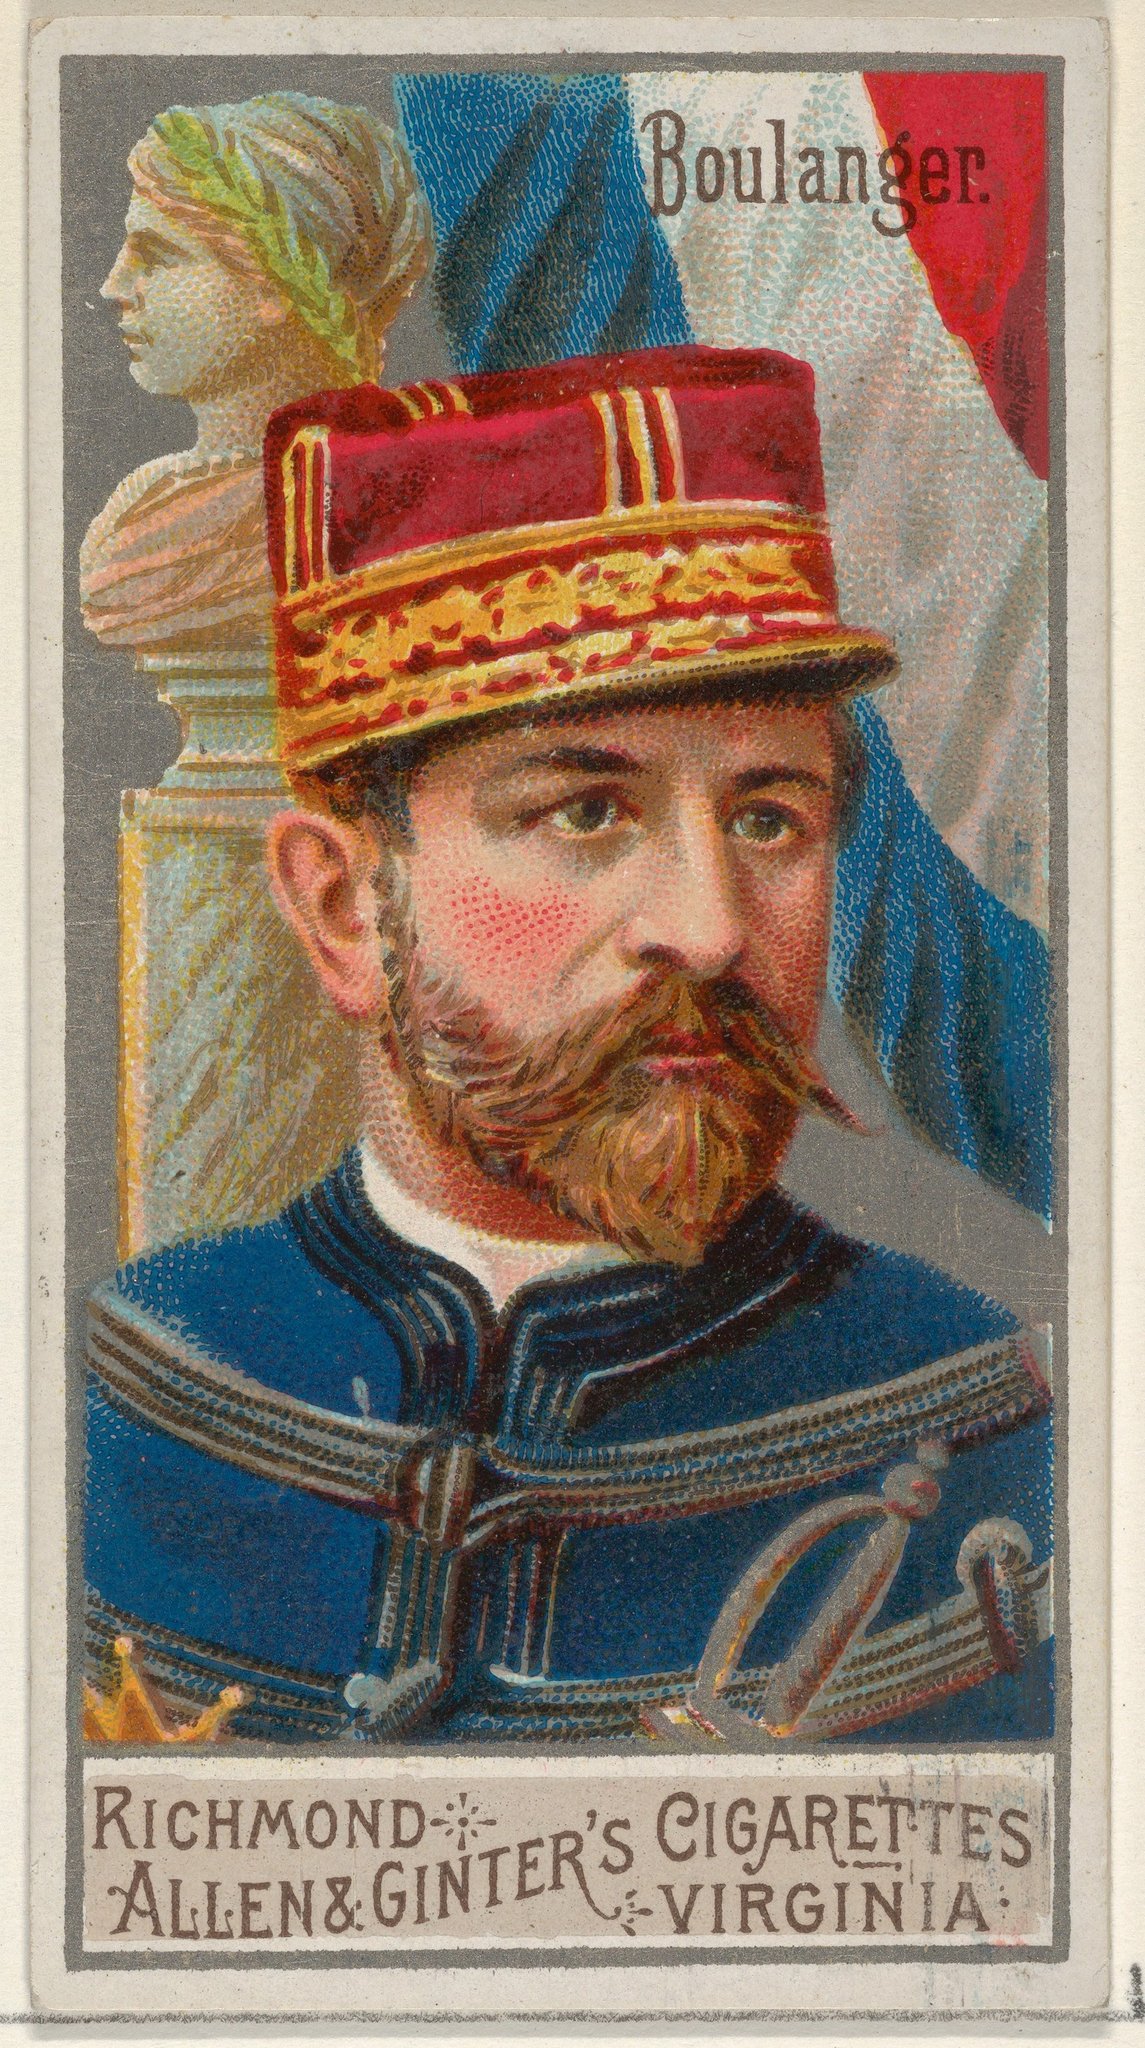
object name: print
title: Georges Ernest Jean-Marie Boulanger, from the Great Generals series (N15) for Allen & Ginter Cigarettes Brands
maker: allen & ginter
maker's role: publisher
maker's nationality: american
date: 1888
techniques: color lithograph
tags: historical figures,men,generals